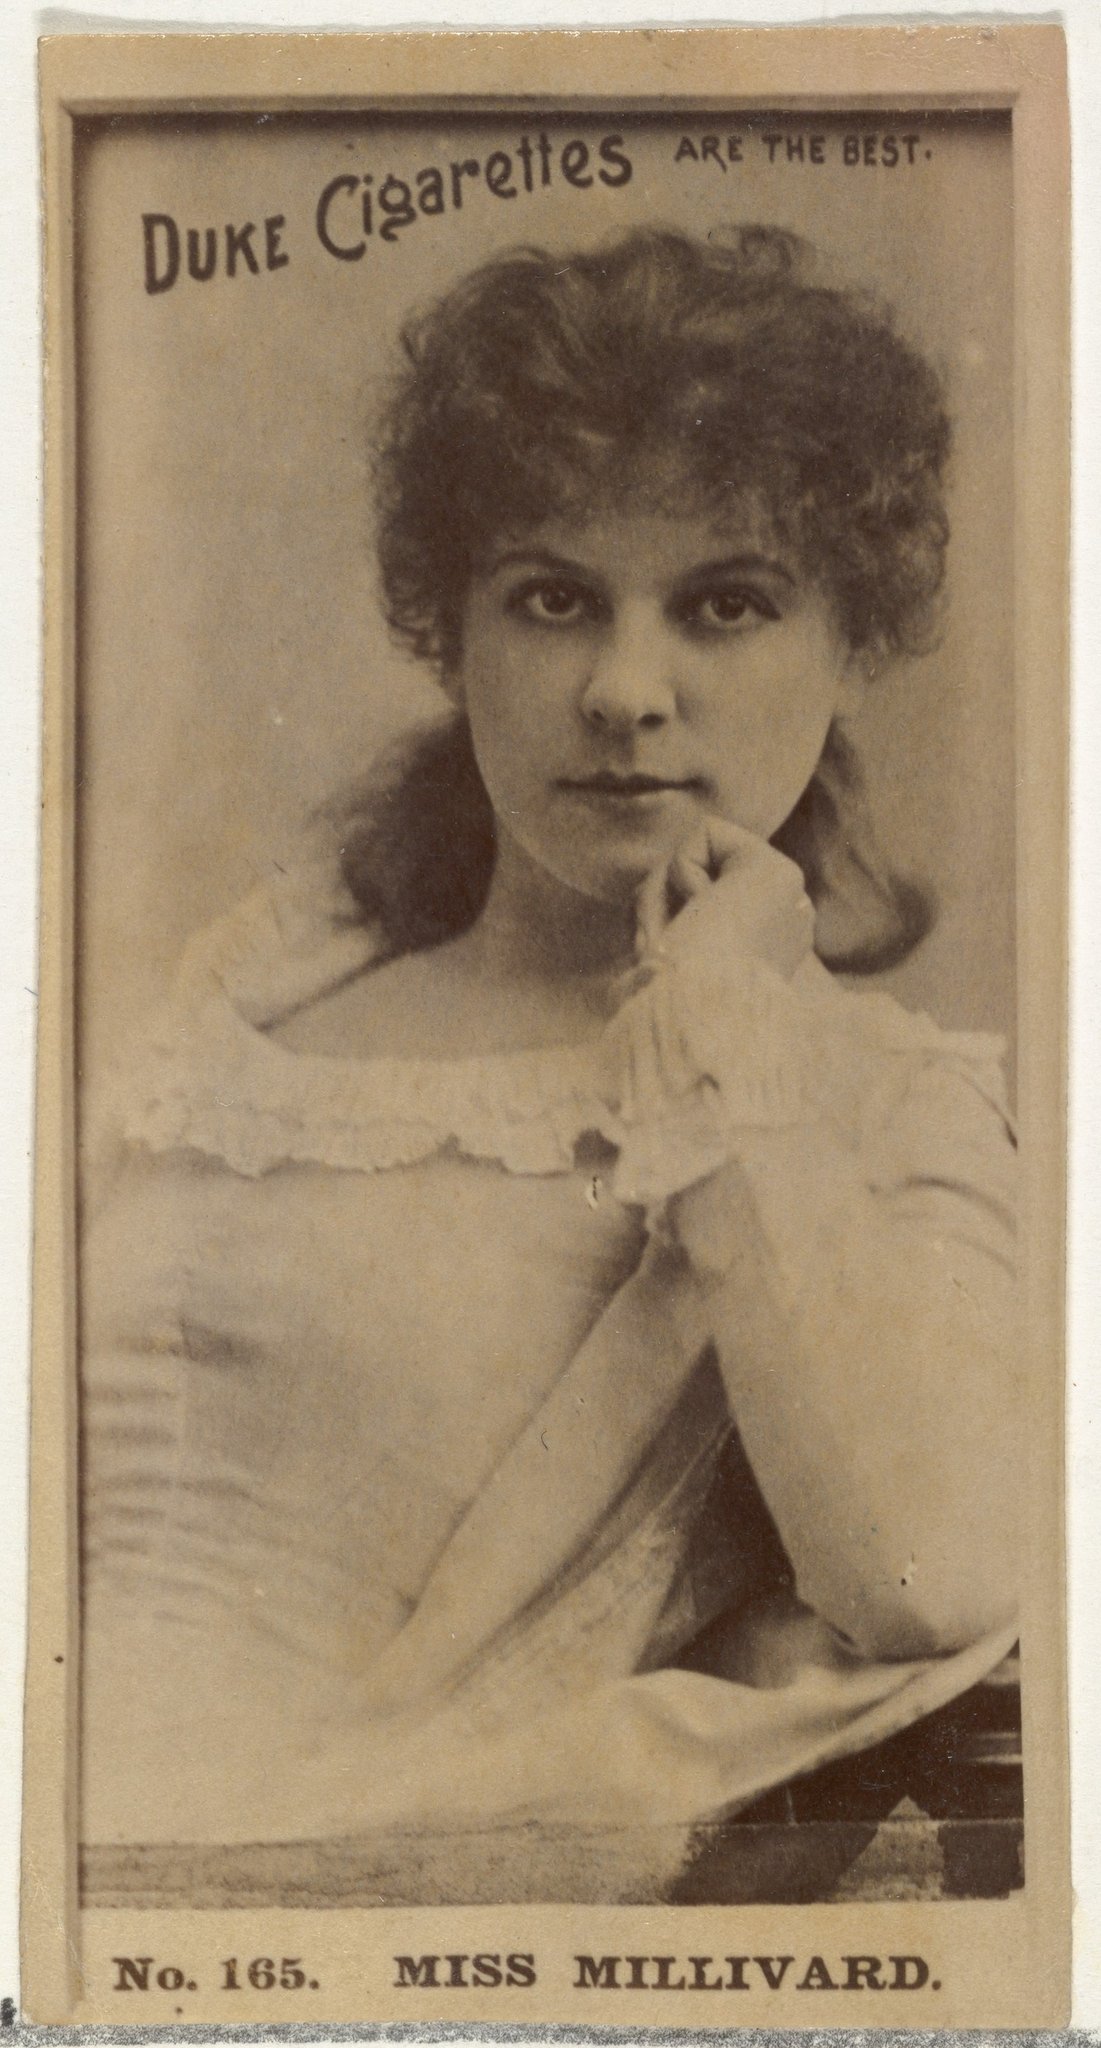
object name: photograph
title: Card Number 165, Miss Millivard, from the Actors and Actresses series (N145-6) issued by Duke Sons & Co. to promote Duke Cigarettes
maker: w. duke, sons & co.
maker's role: publisher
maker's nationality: american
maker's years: 1870-1920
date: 1880-1889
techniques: albumen silver print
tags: portraits,women,actresses